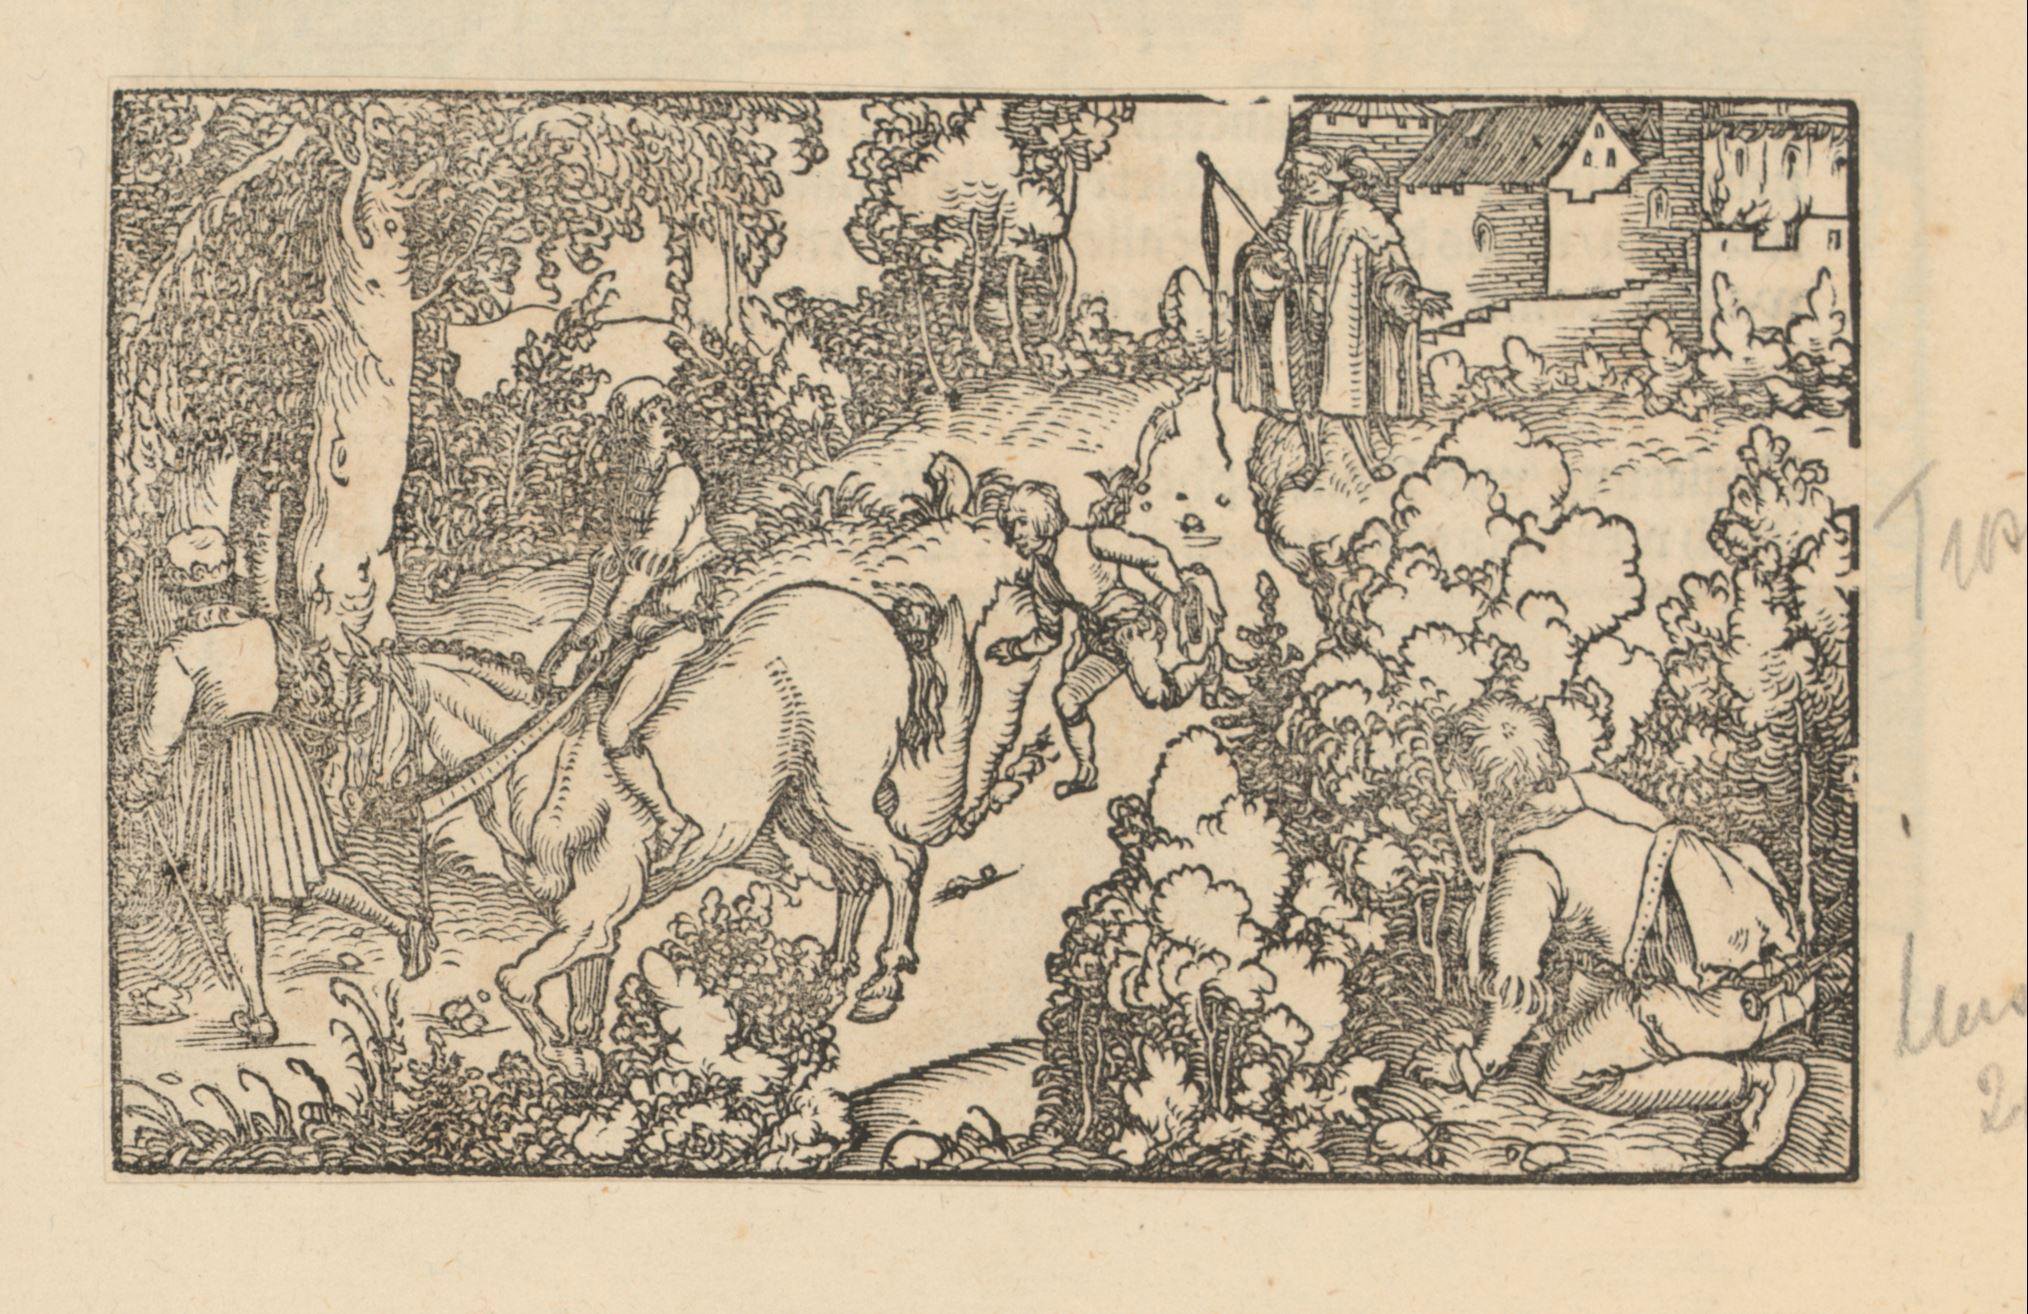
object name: book illustration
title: Mannen rennen weg van de landvoogd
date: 1514-1532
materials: paper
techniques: letterpress printing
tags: bolting, running away (~ horse), bailiff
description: Deze prent is gebruikt in: Petrarca, Francesco. Von der Artzney bayder Glück, des guten und widerwertigen: unnd weß sich ain yeder inn Gelück und Unglück halten sol (...). Augsburg: Heinrich Steiner, 1532. Deze uitgave is ook bekend onder de titel 'Trostspiegel in Glück und Unglück'. Deze prent is ook gebruikt in: Cicero, Marcus Tulius. Officia M.T.C. Ein Buch so Marcus Tullius Cicero der Römer zu seynem (...). [Vertaald uit het Latijn door] Johann von Schwarzenberg. Augsburg: Heinrich Steiner, 1531.